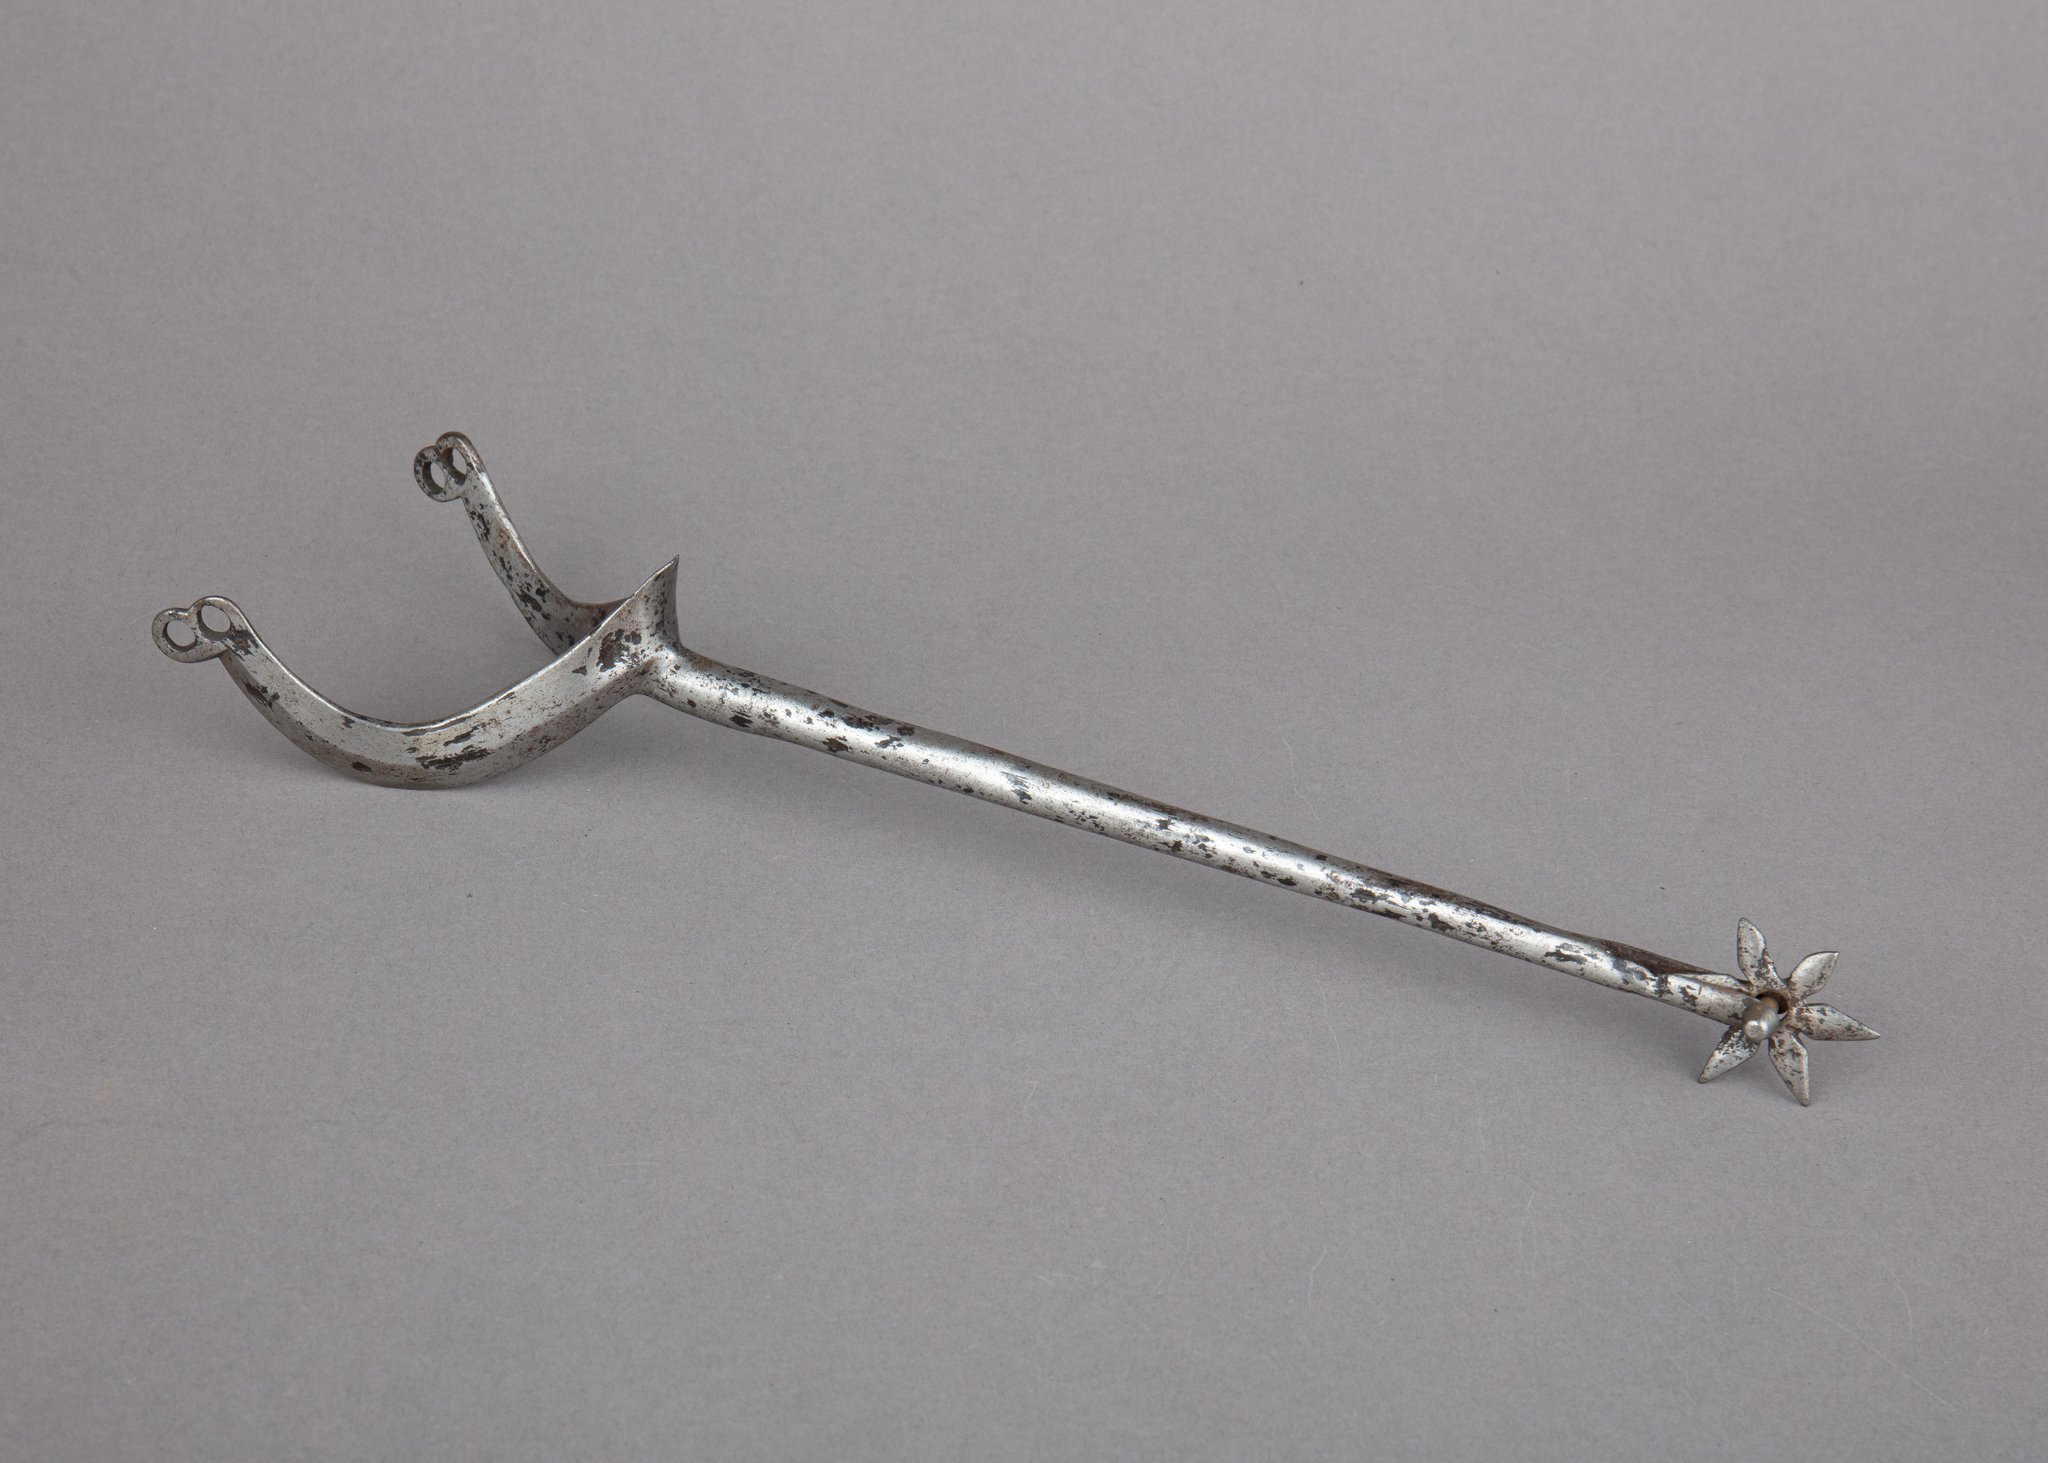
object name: spur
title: Rowel Spur (Left)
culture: french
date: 1401-1500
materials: metal alloy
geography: france